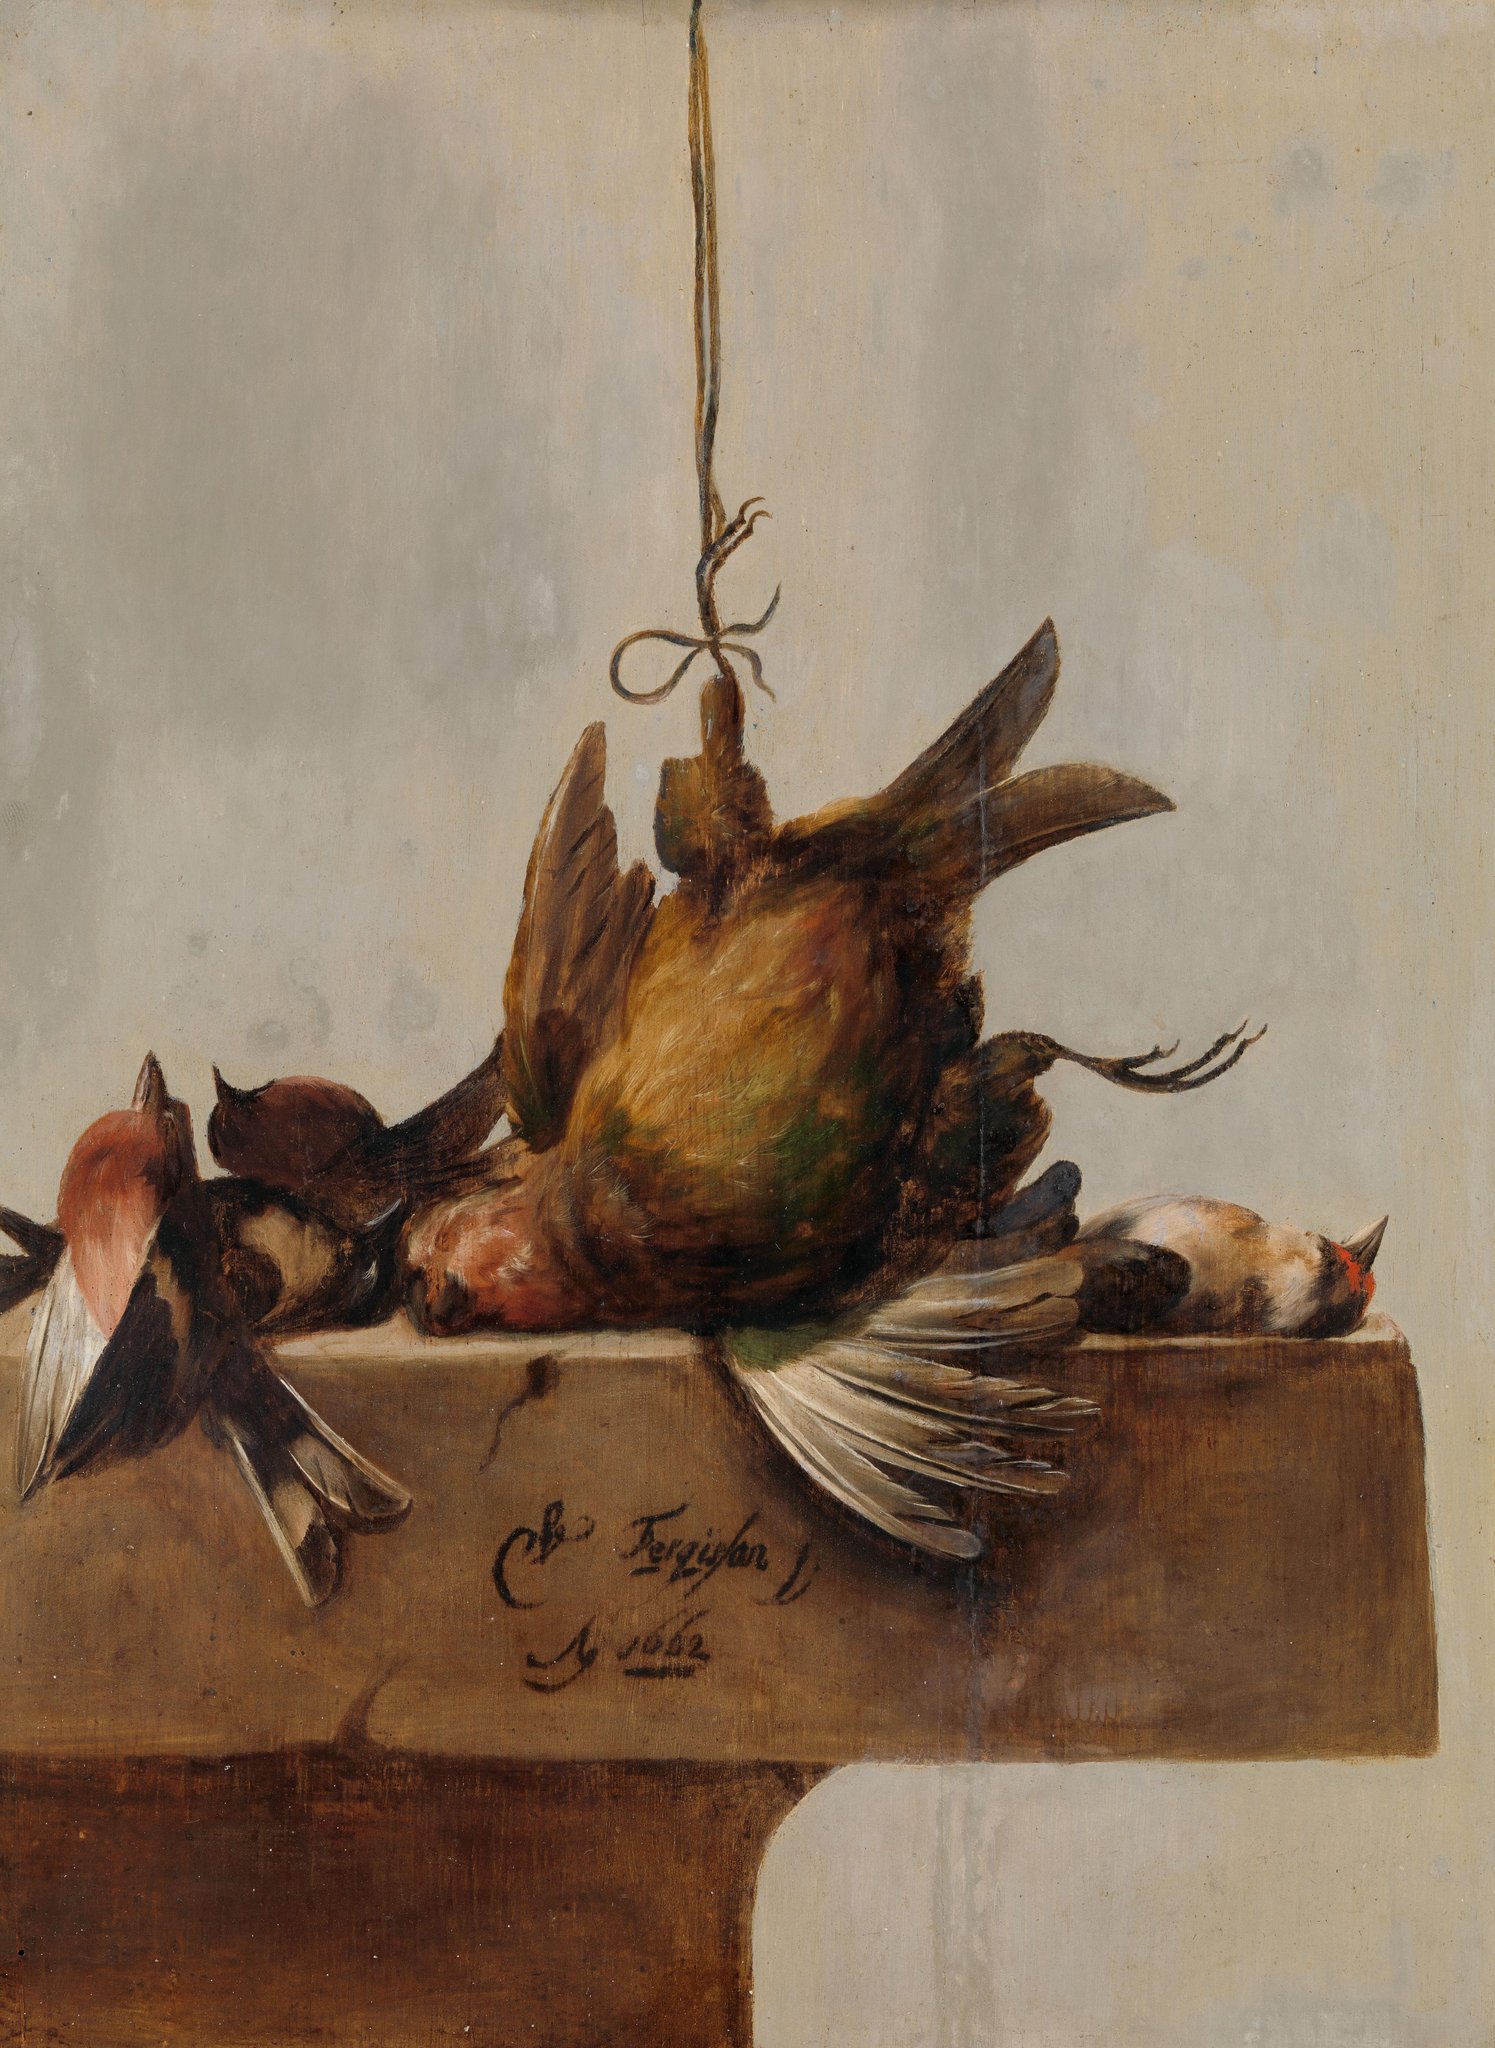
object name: painting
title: Still Life with Birds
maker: william gowe ferguson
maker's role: painter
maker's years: 1632-1695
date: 1662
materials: oil, panel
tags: still life of related objects, birds (+ dying animal; death of animal; dead animal), foodstuffs; still life of foodstuffs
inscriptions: signature and date: ‘WG Ferguson f. Aº 1662’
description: Stilleven met vogels. Op een stenen plint liggen verschillende dode vogels, waarvan één aan een pootje is opgehangen.